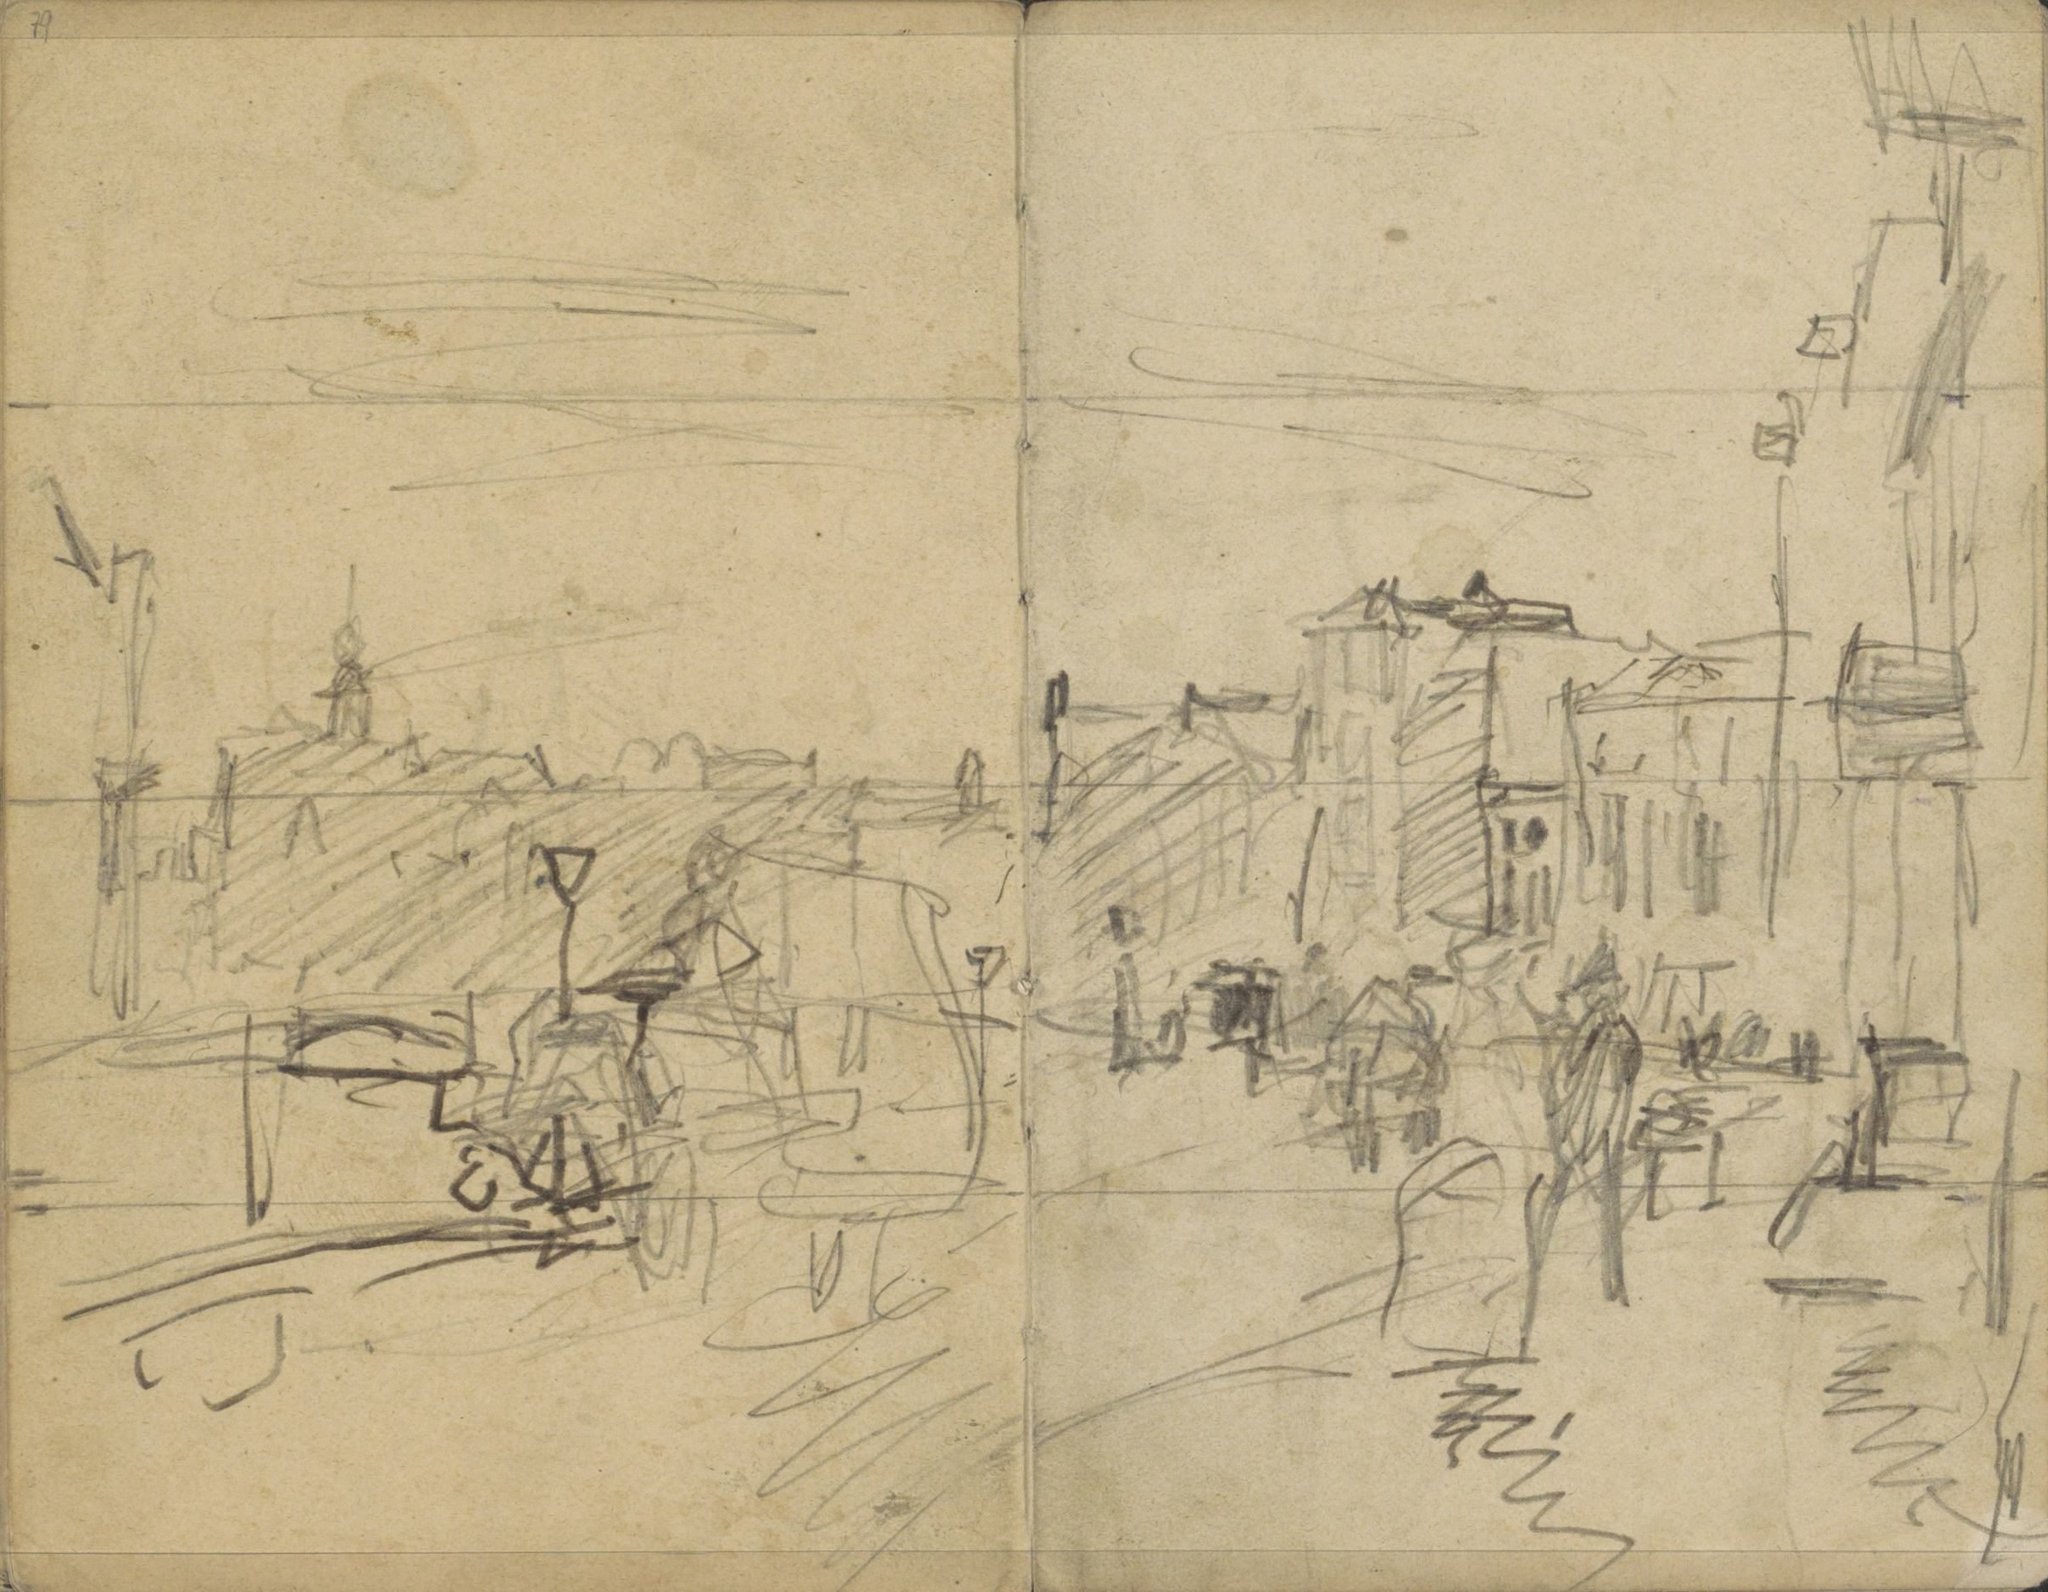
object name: sketchbook leaf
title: Gezicht op het Rokin te Amsterdam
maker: george hendrik breitner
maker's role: draughtsman, painter, print maker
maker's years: 1857-1923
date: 1903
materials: paper, pencil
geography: amsterdam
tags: urban housing, canals, waters (in city) (+ city(-scape) with figures, staffage)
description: Gezicht op het Rokin te Amsterdam. Pagina 79 en pagina 80 uit een schetsboek met 46 bladen vervaardigd te Amsterdam en Haarlem.